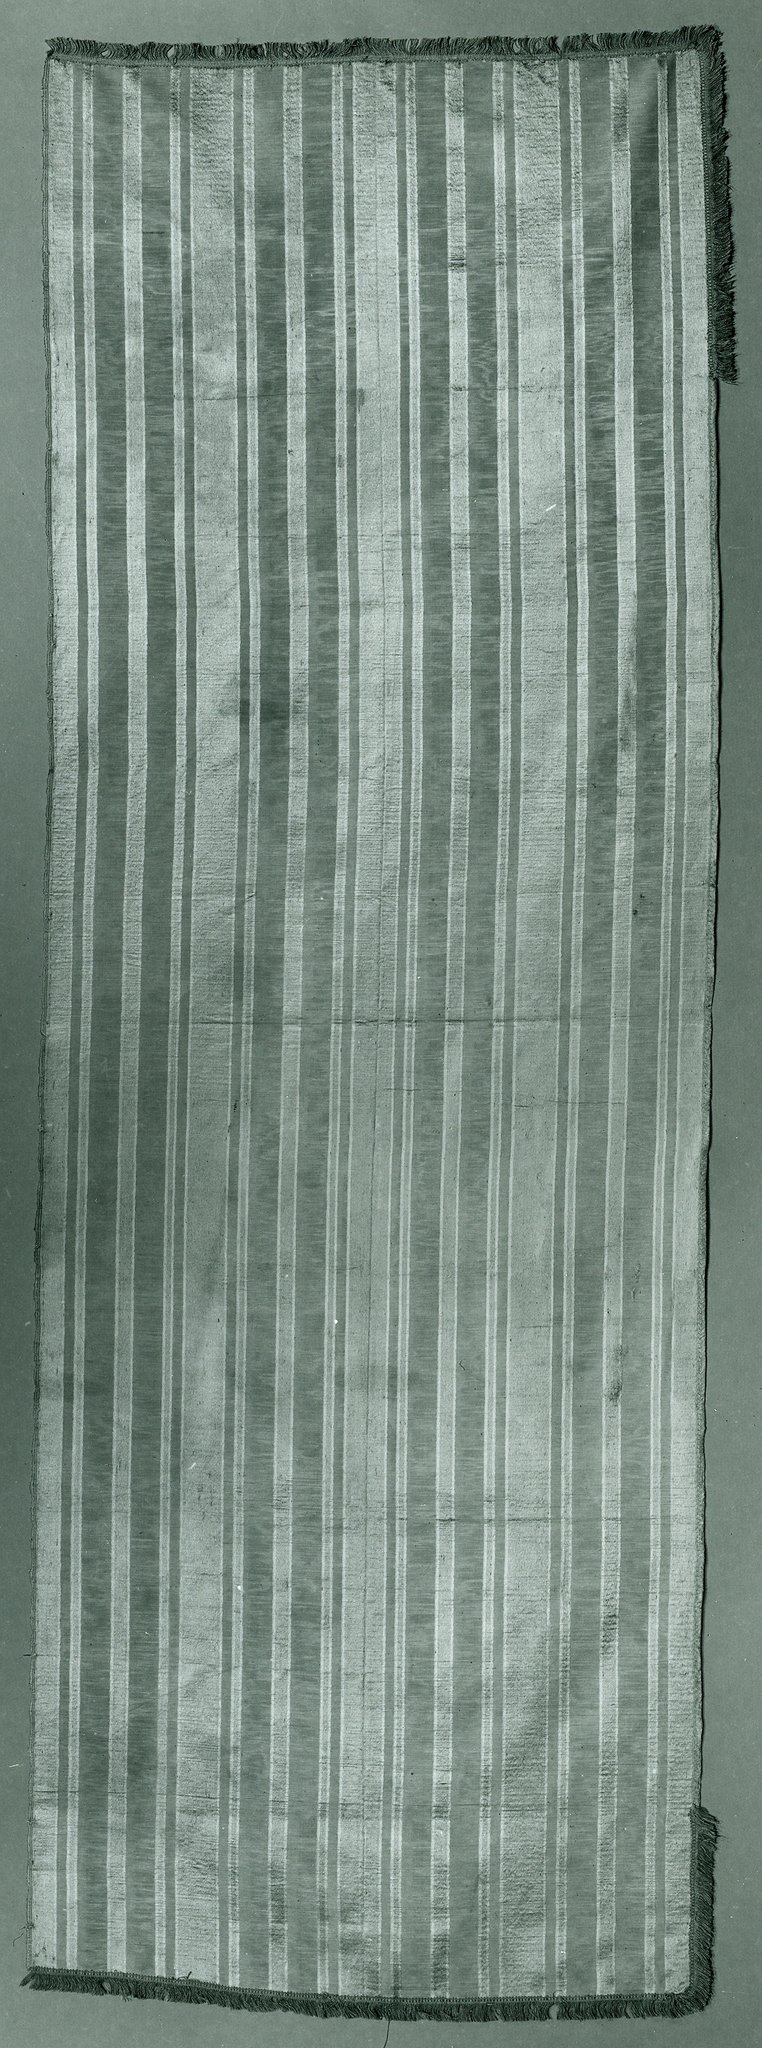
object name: textile cover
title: Cover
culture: french or italian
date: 1767-1833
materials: silk